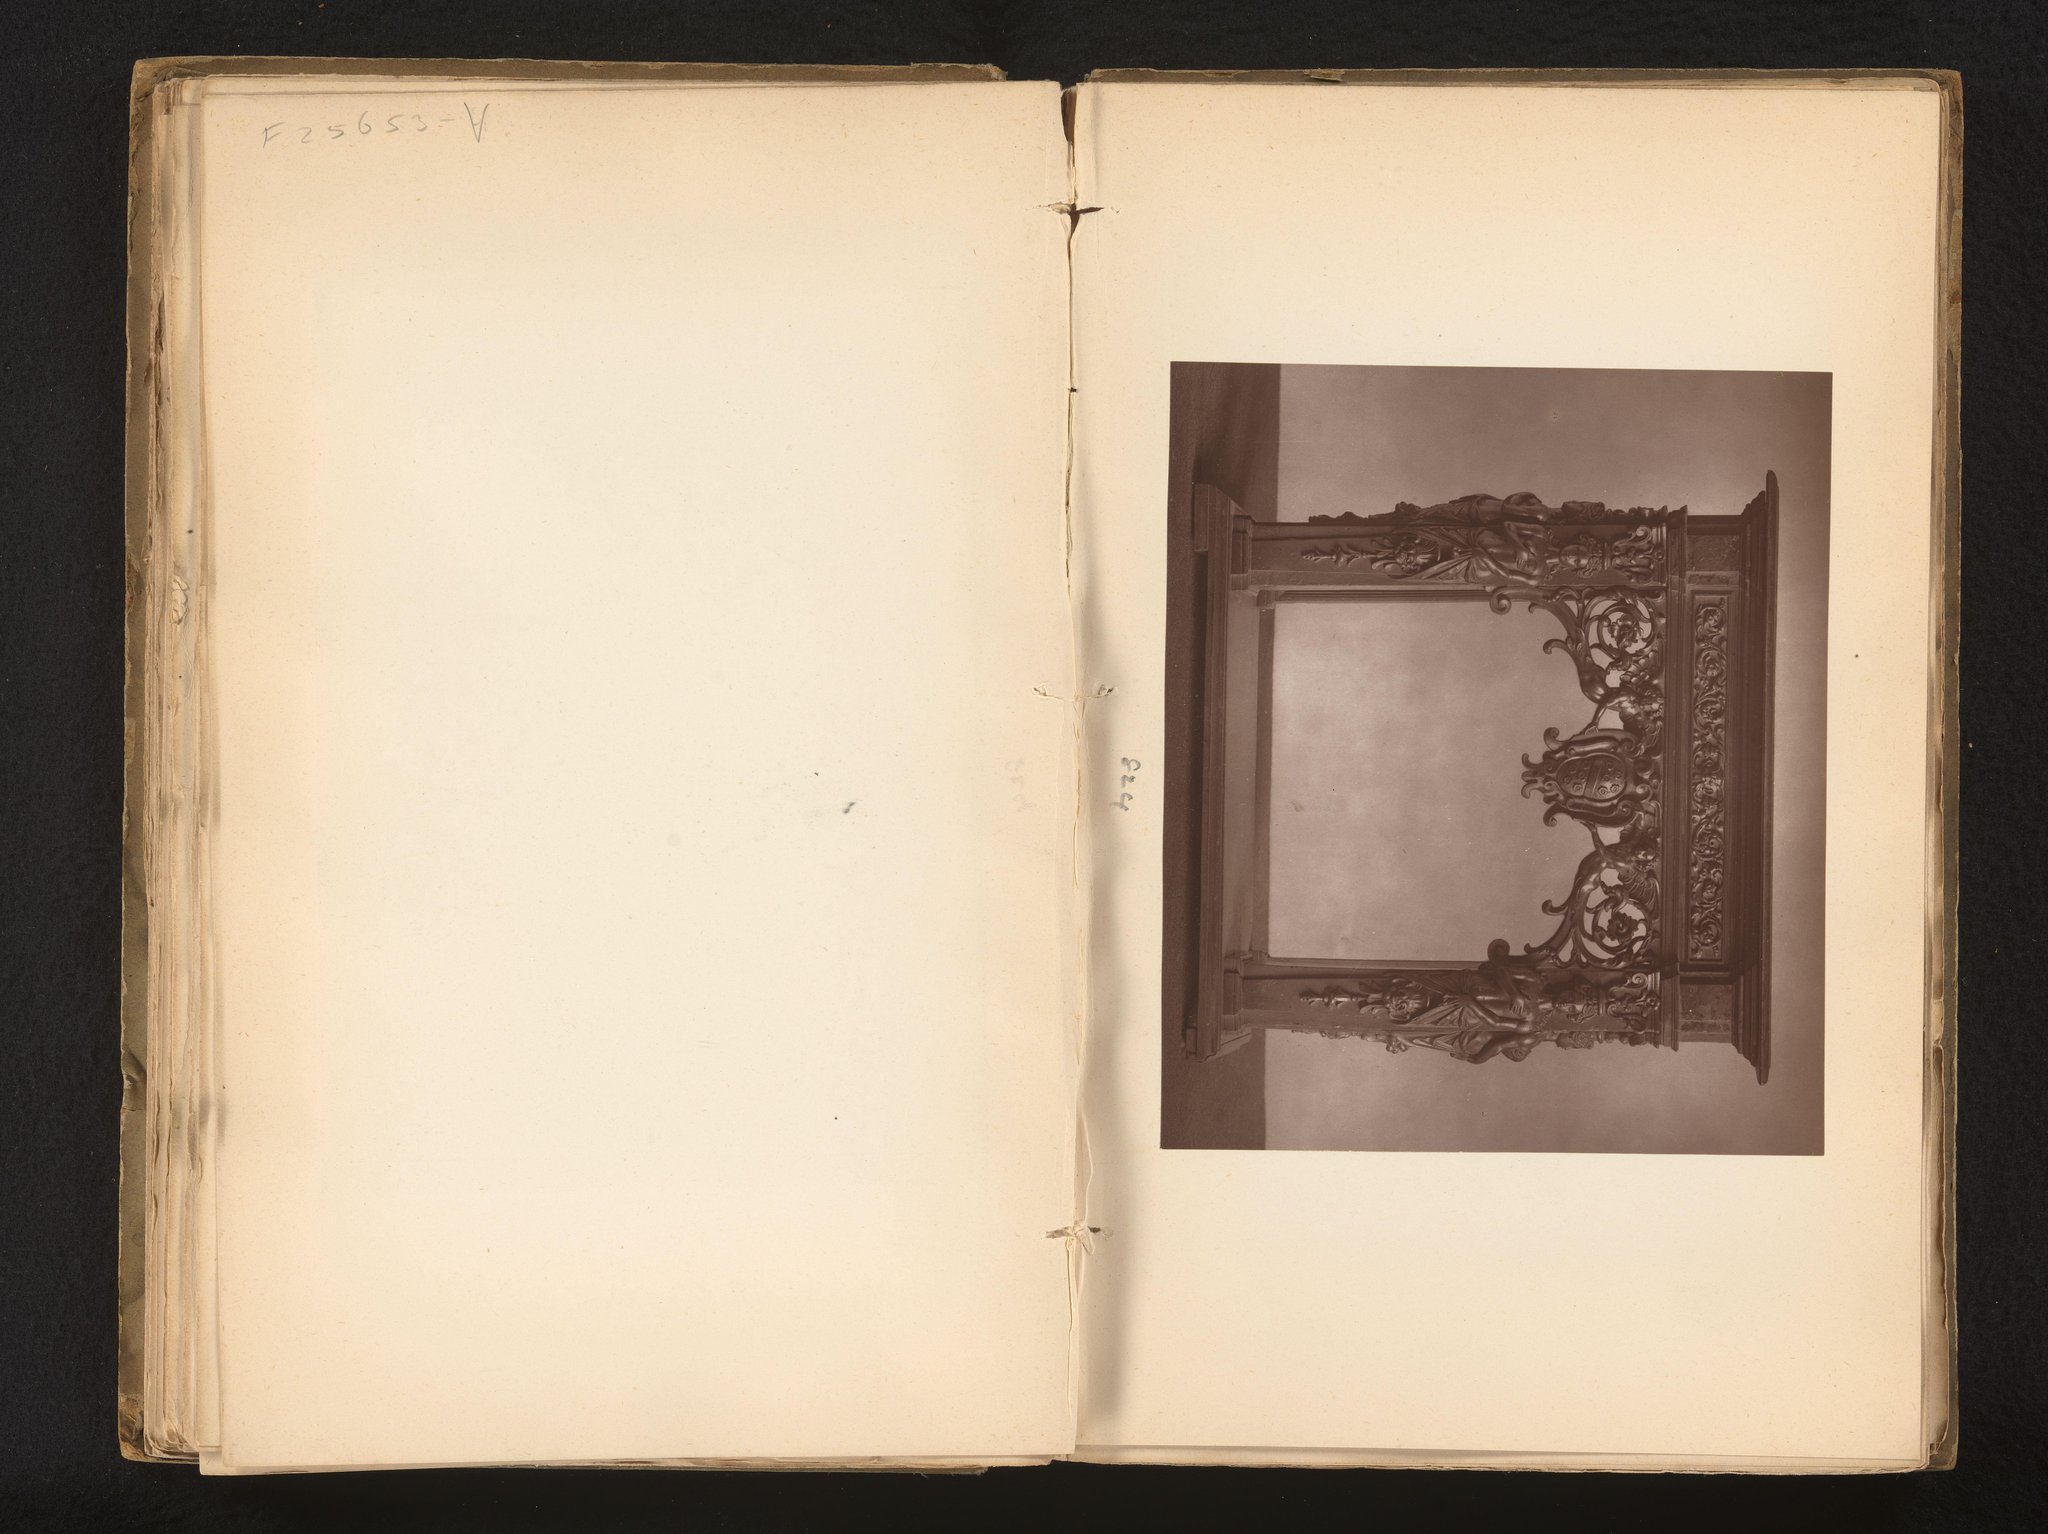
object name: page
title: Italiaans voetstuk van walnoothout, uit de collectie van Christopher Beckett Denison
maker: Anonymous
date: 1880-1885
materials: paper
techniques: woodburytype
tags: pedestal of a piece of sculpture (perhaps in the form of a herm) (+ wood, e.g.: panel ~ arts)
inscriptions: number: ‘824’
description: Prent op zevende ongenummerde pagina na pagina 82.